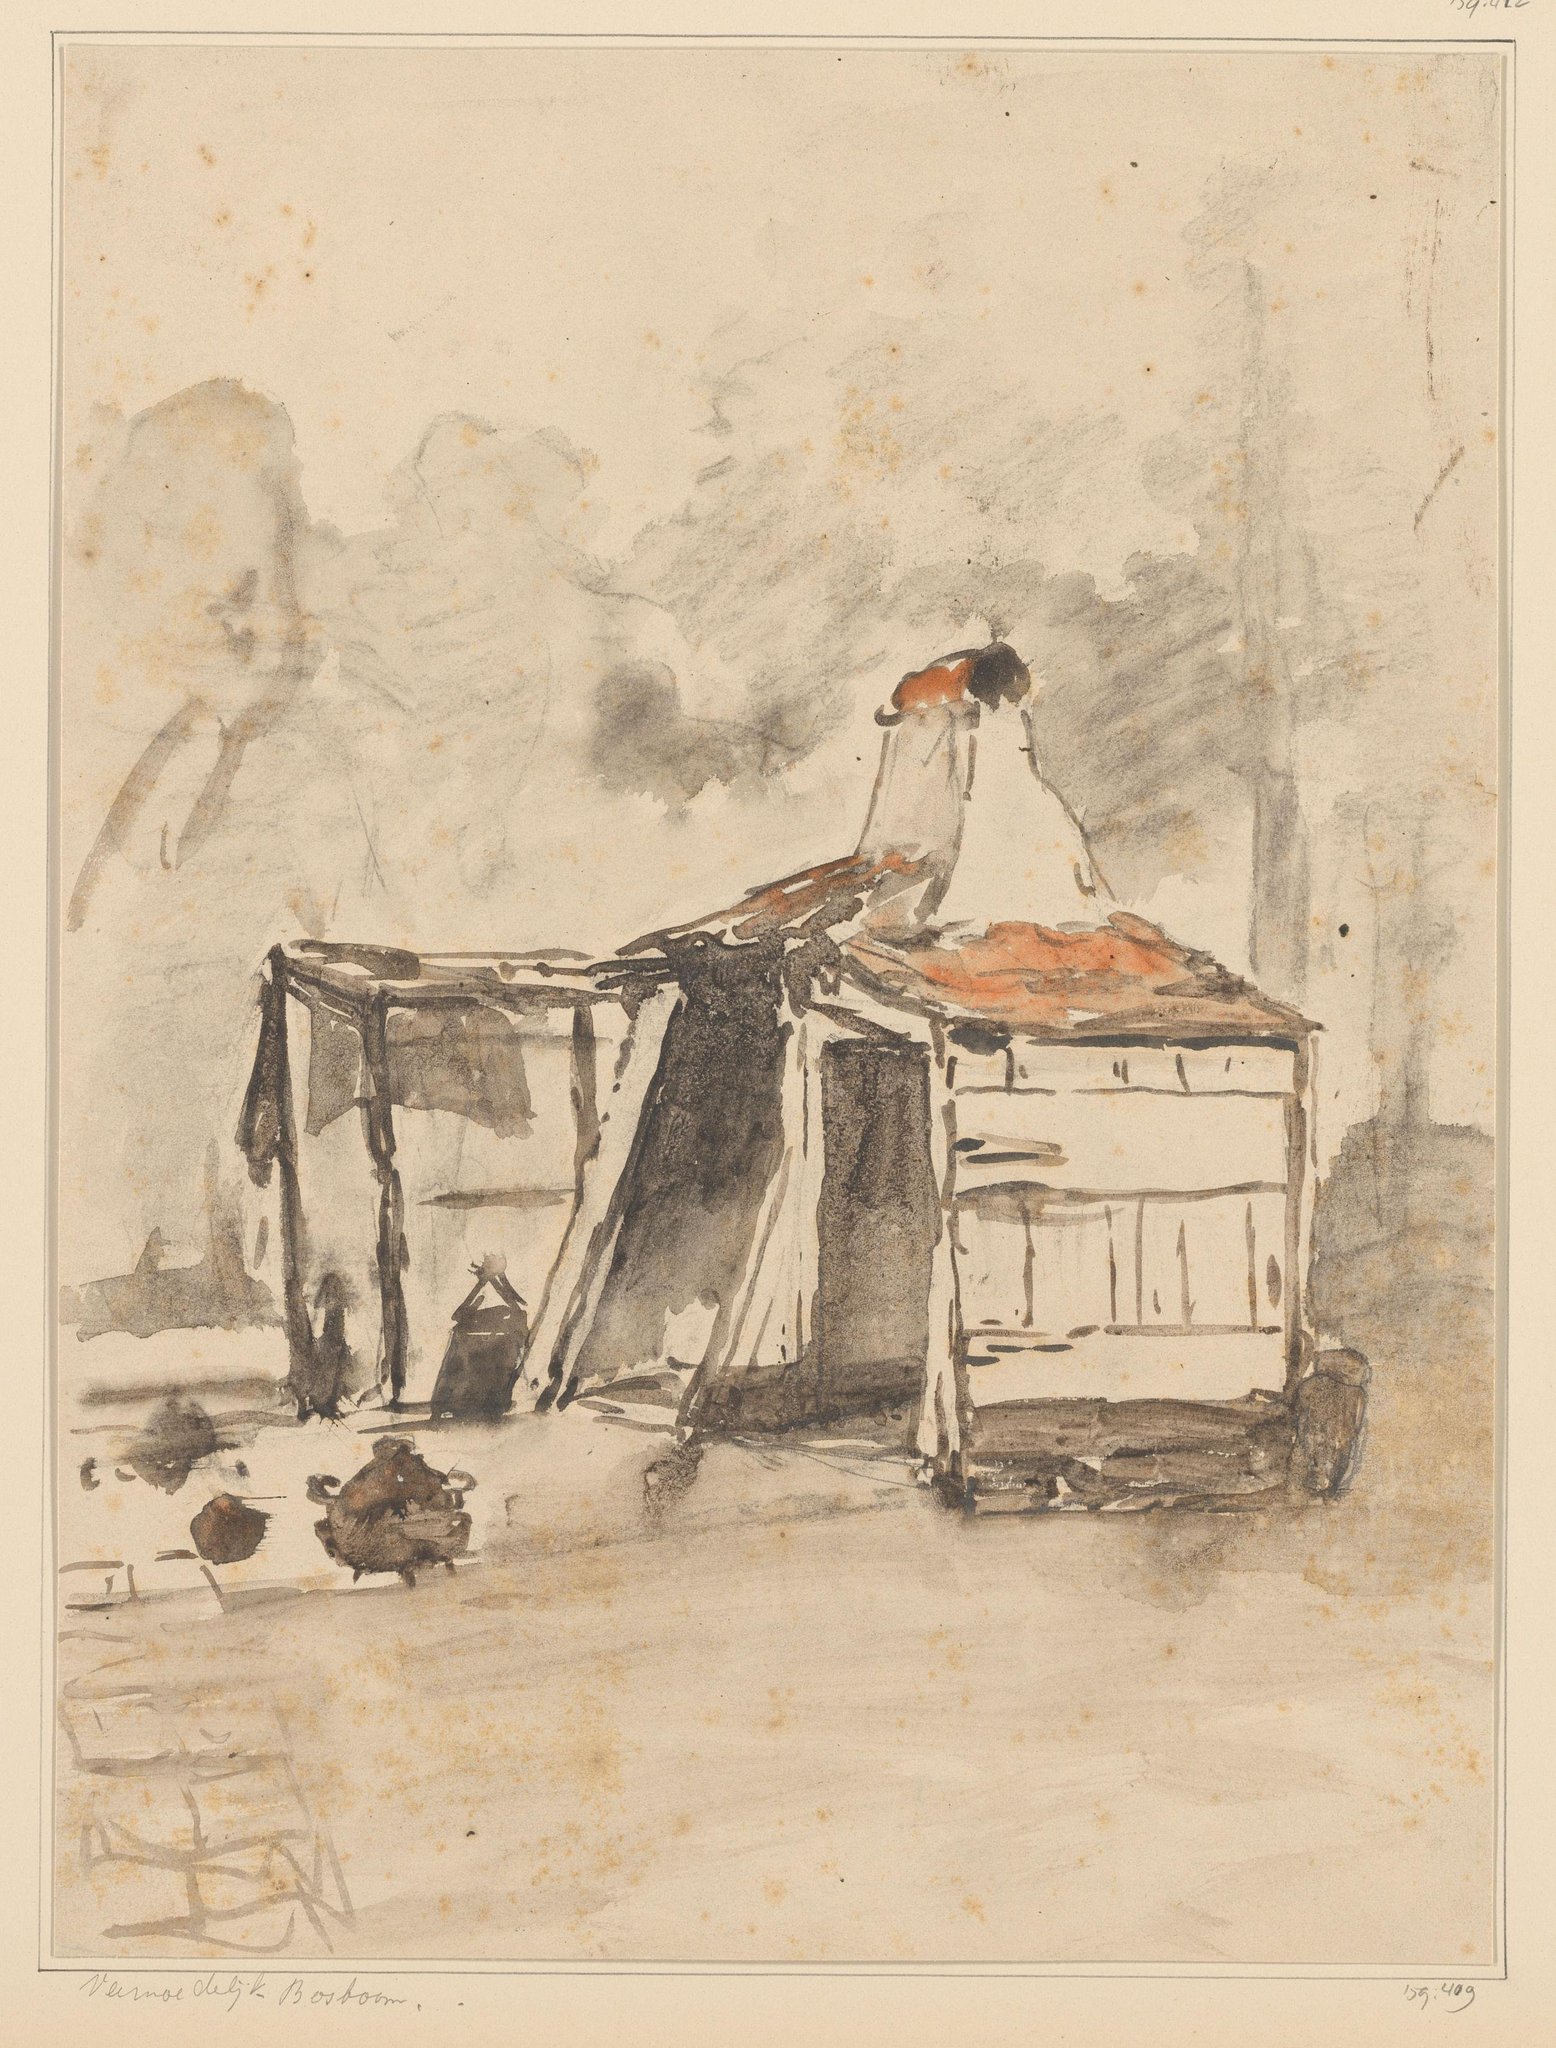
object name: drawing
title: Schuur of stal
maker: johannes bosboom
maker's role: draughtsman, painter, print maker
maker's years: 1817-1891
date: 1827-1891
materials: paper, watercolor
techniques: brush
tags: shed, stall, stable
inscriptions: inscription: ‘Vermoedelijk Bosboom’